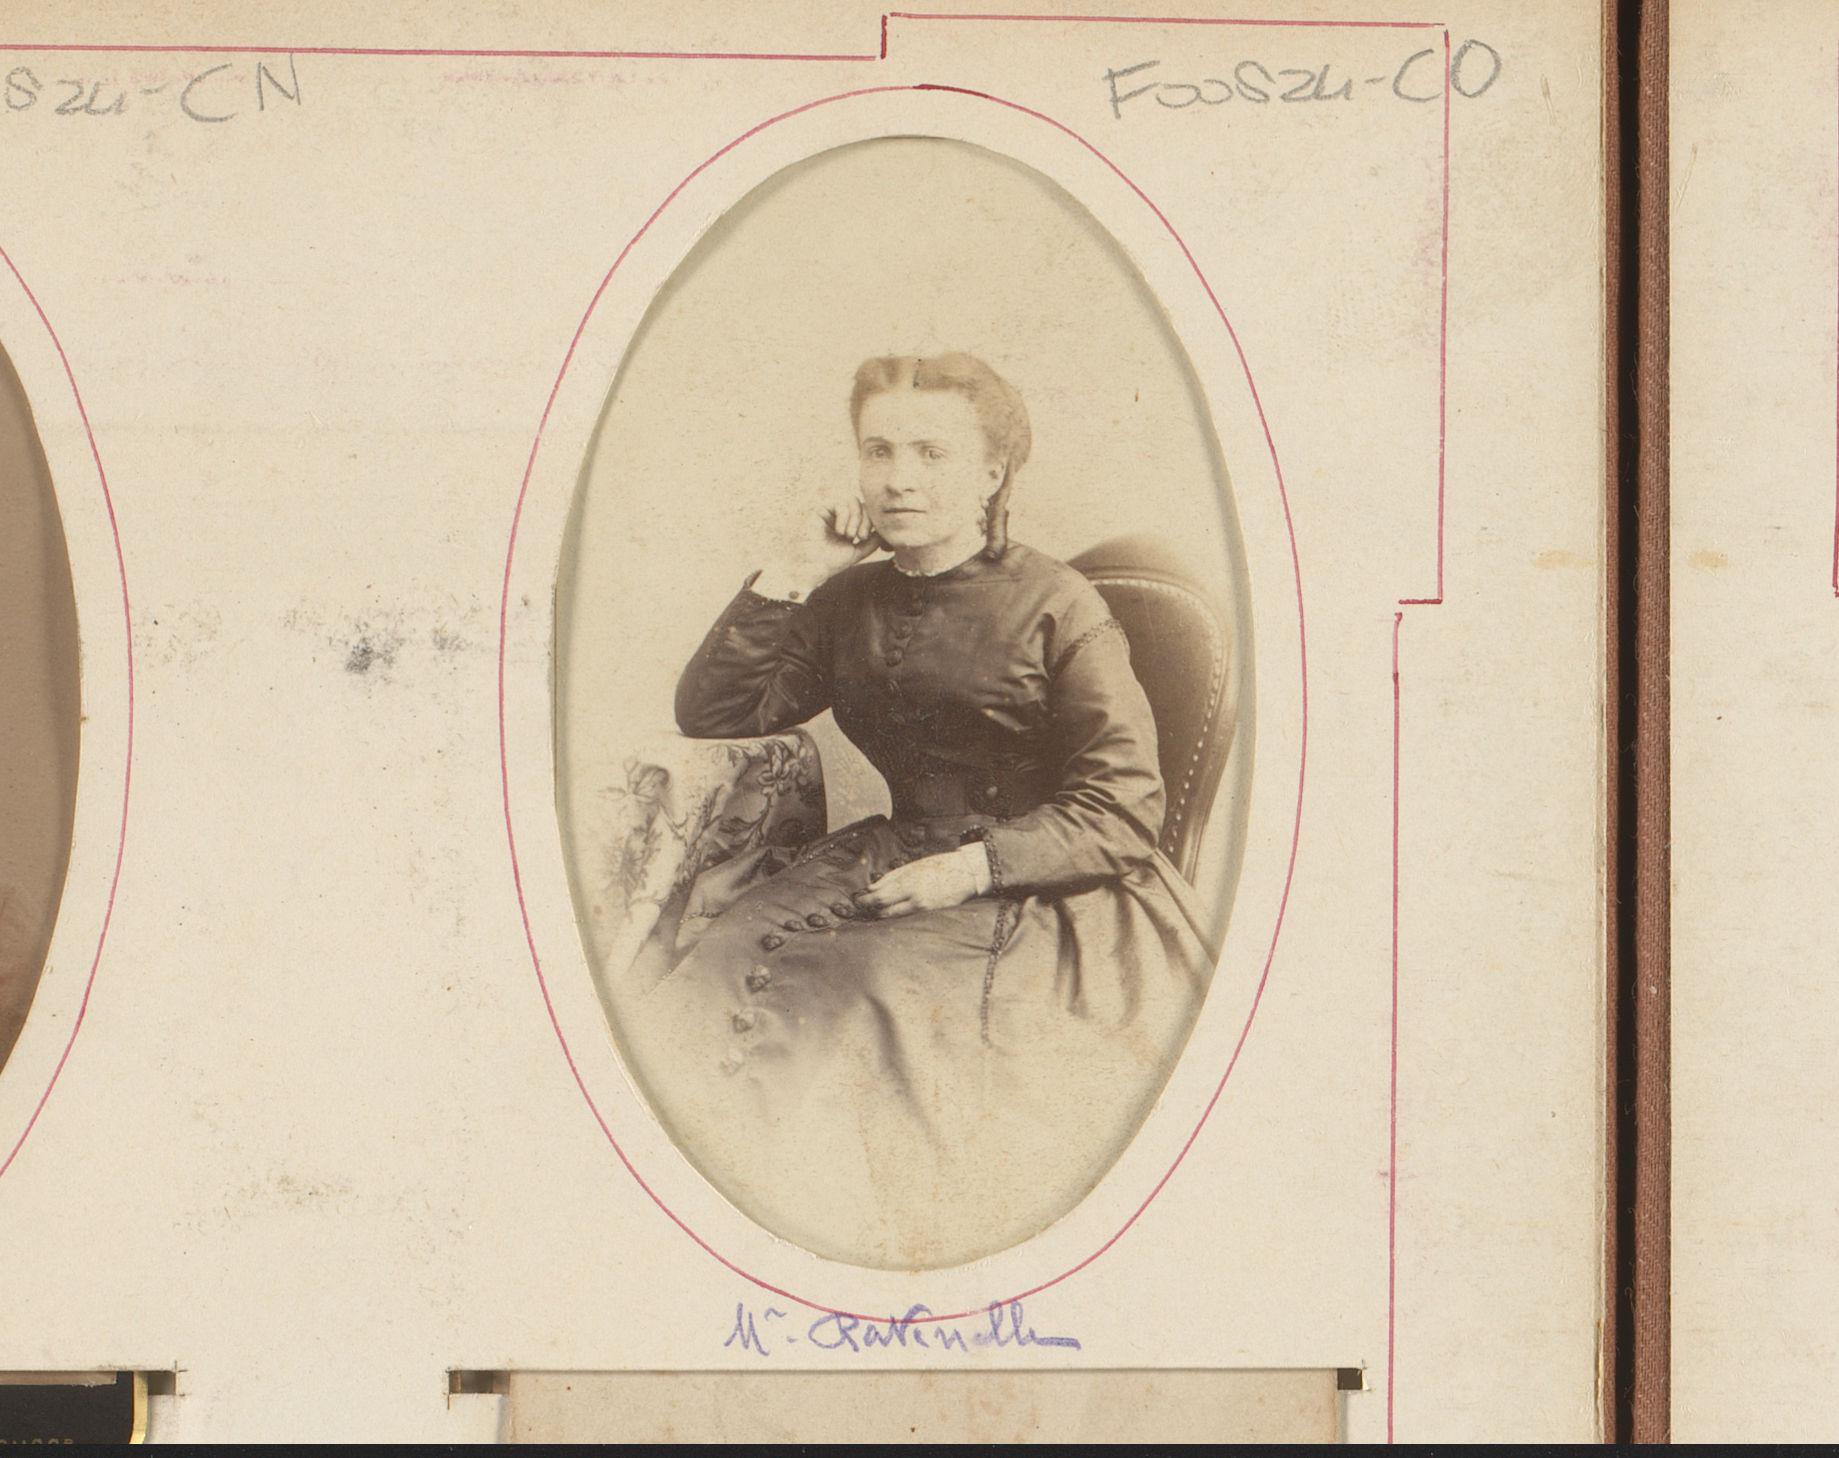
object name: carte de visite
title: Portret van een vrouw, aangeduid als Mme. Pavenelle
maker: victor françois girard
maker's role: fotograaf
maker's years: 1835-1893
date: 1866-1893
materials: cardboard, paper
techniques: albumen print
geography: nantes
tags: adult woman, anonymous historical person portrayed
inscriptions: address: ‘16, rue Boileau, 16,/ NANTES.’